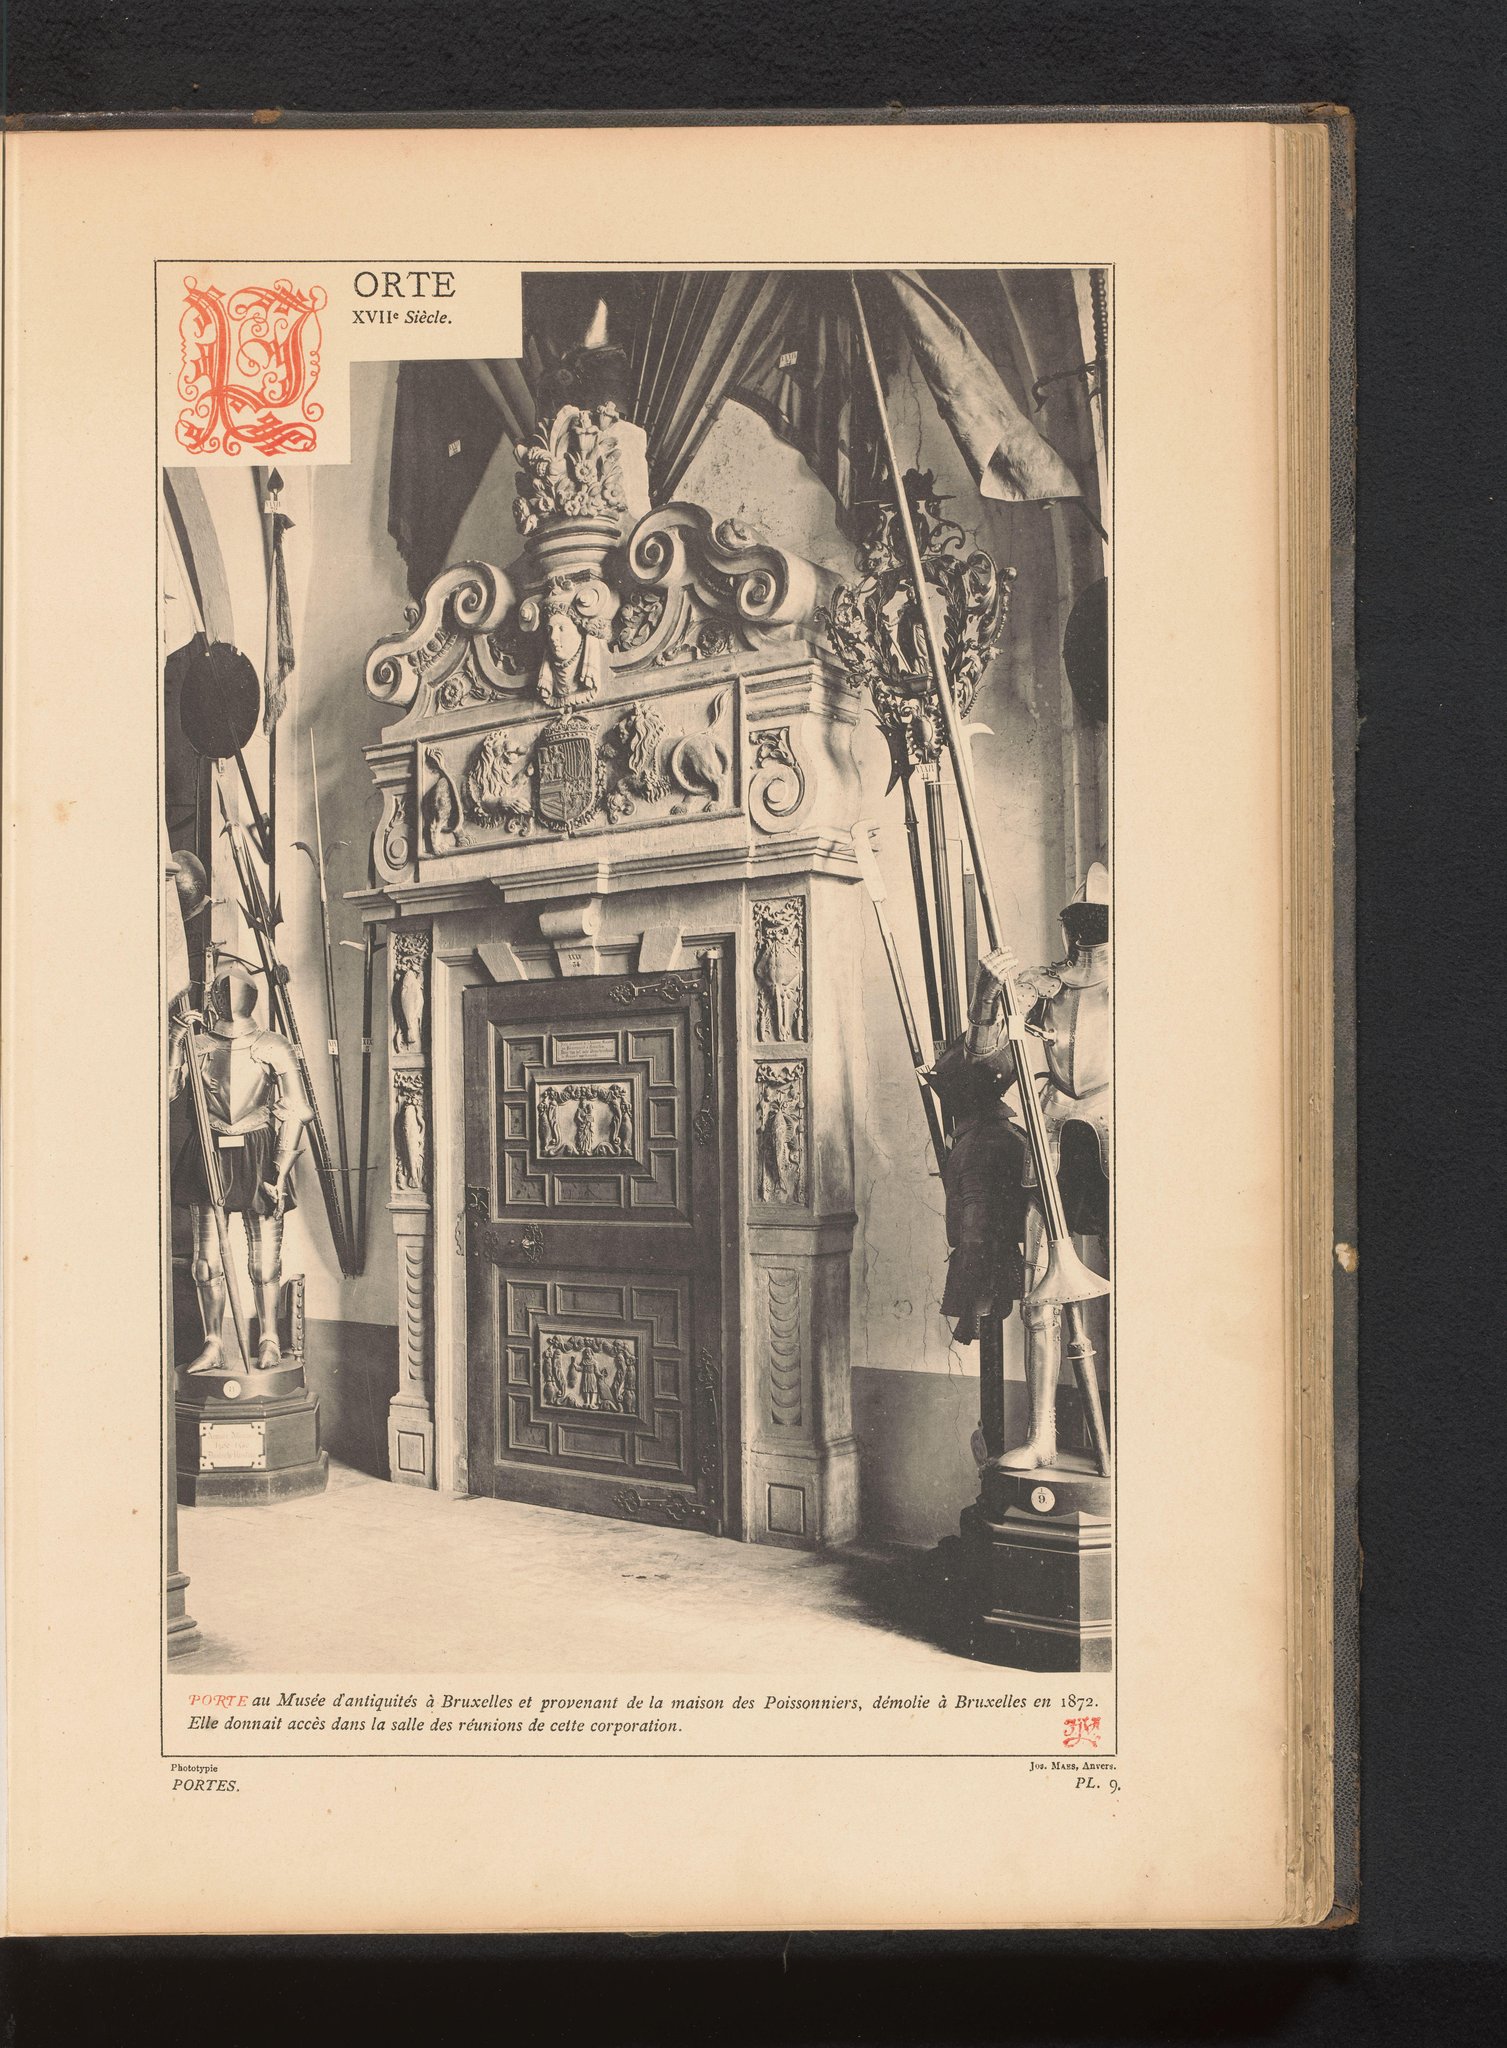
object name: photomechanical print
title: Porte XVIIe, Siècle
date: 1881-1889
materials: paper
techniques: photograph, photolithography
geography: brussels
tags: door, brussels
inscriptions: inscription: ‘PORTE au Musée (...)’, inscription: ‘PORTES. PL. 9.’, monogram: ‘JJvY’